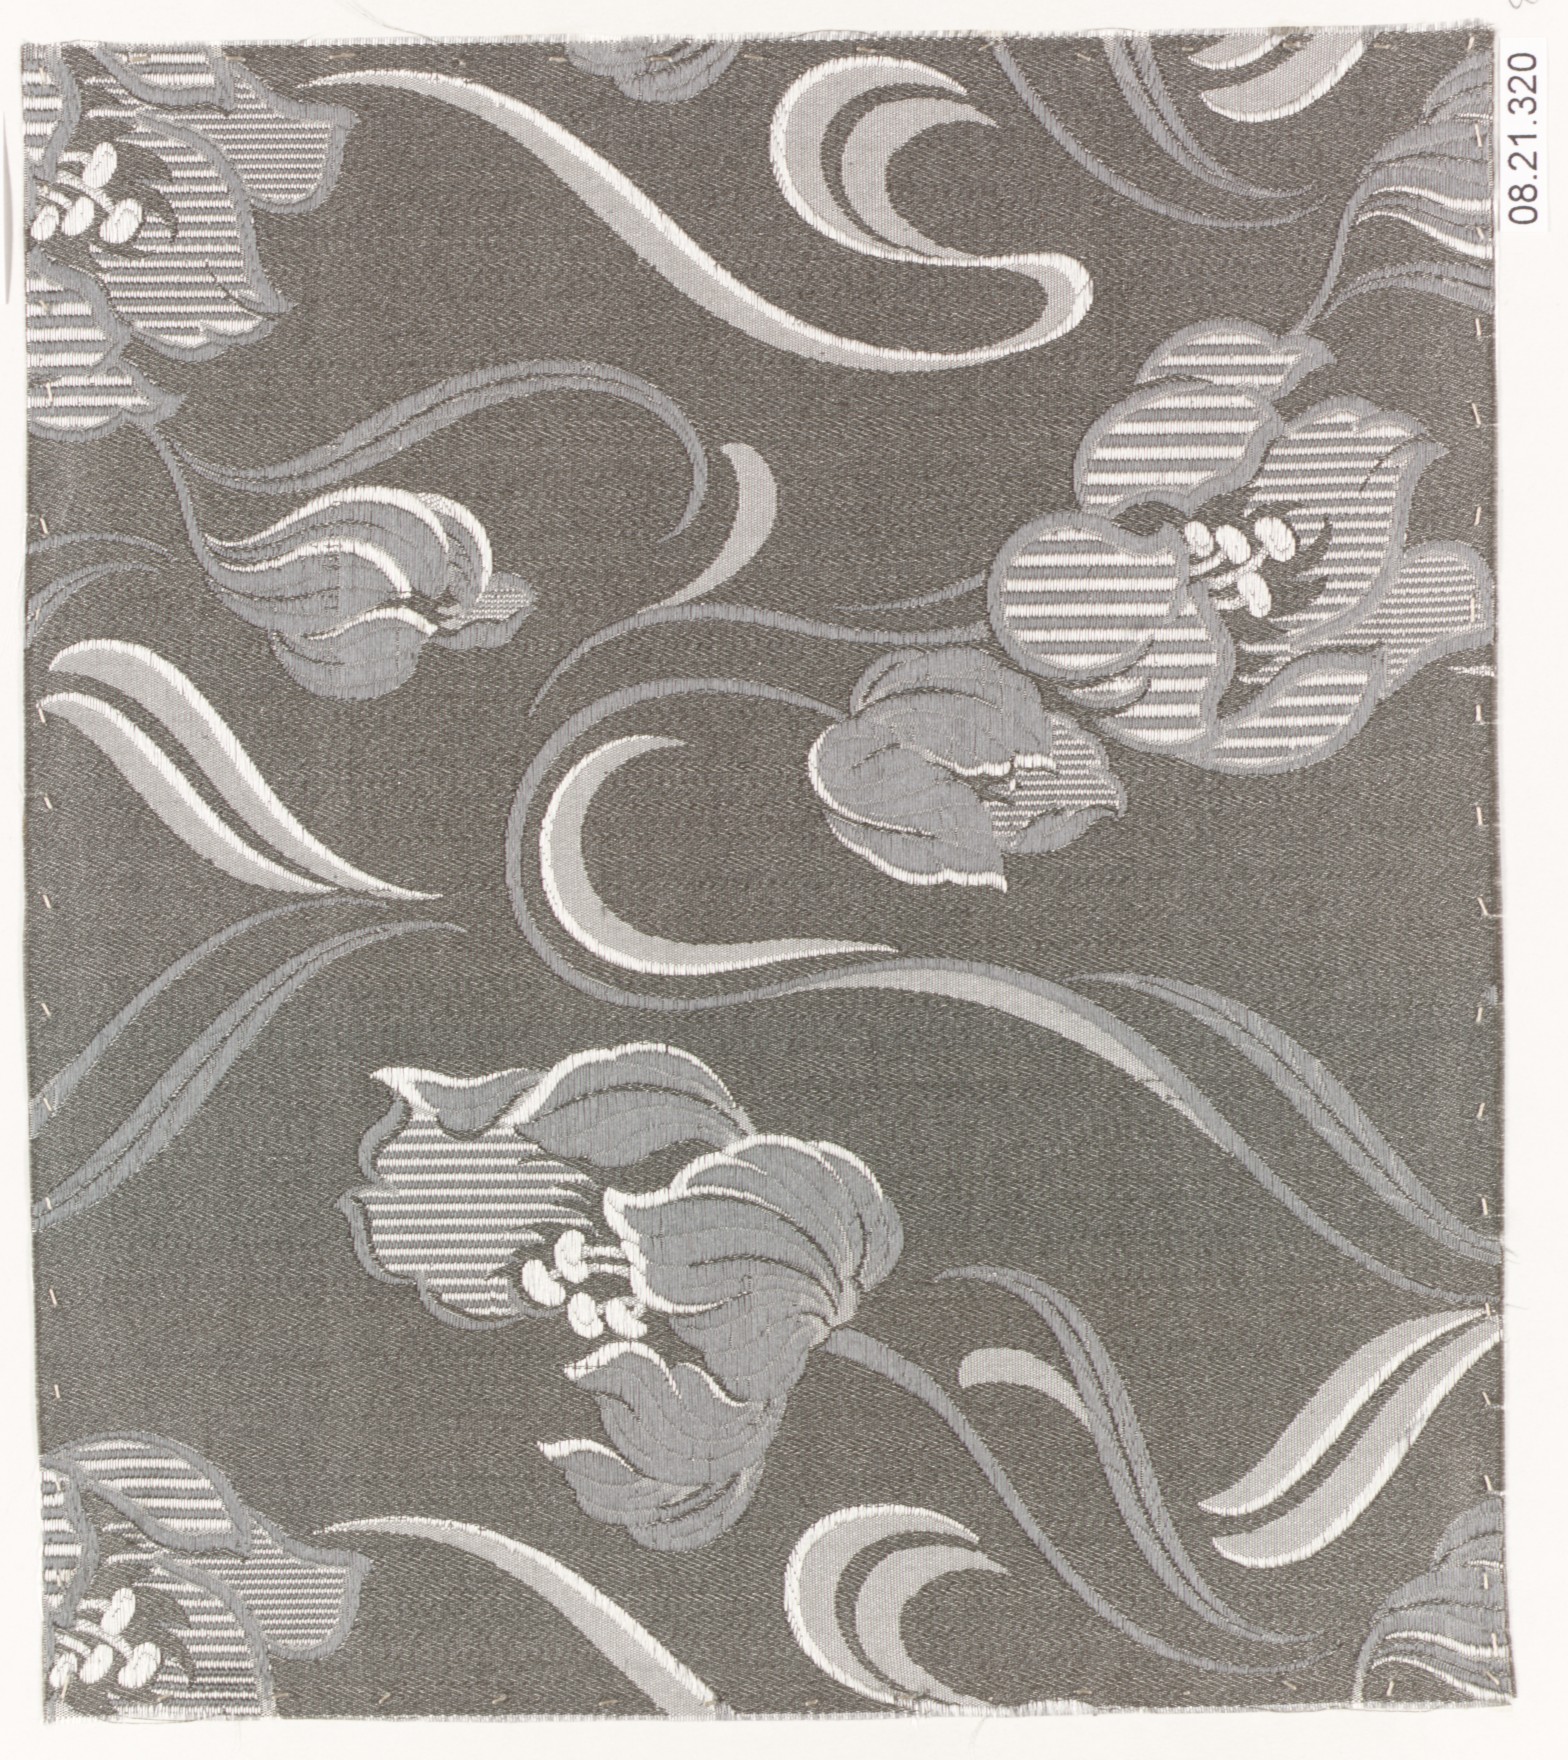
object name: textile sample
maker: Anonymous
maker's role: designer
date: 1900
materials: silk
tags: flowers